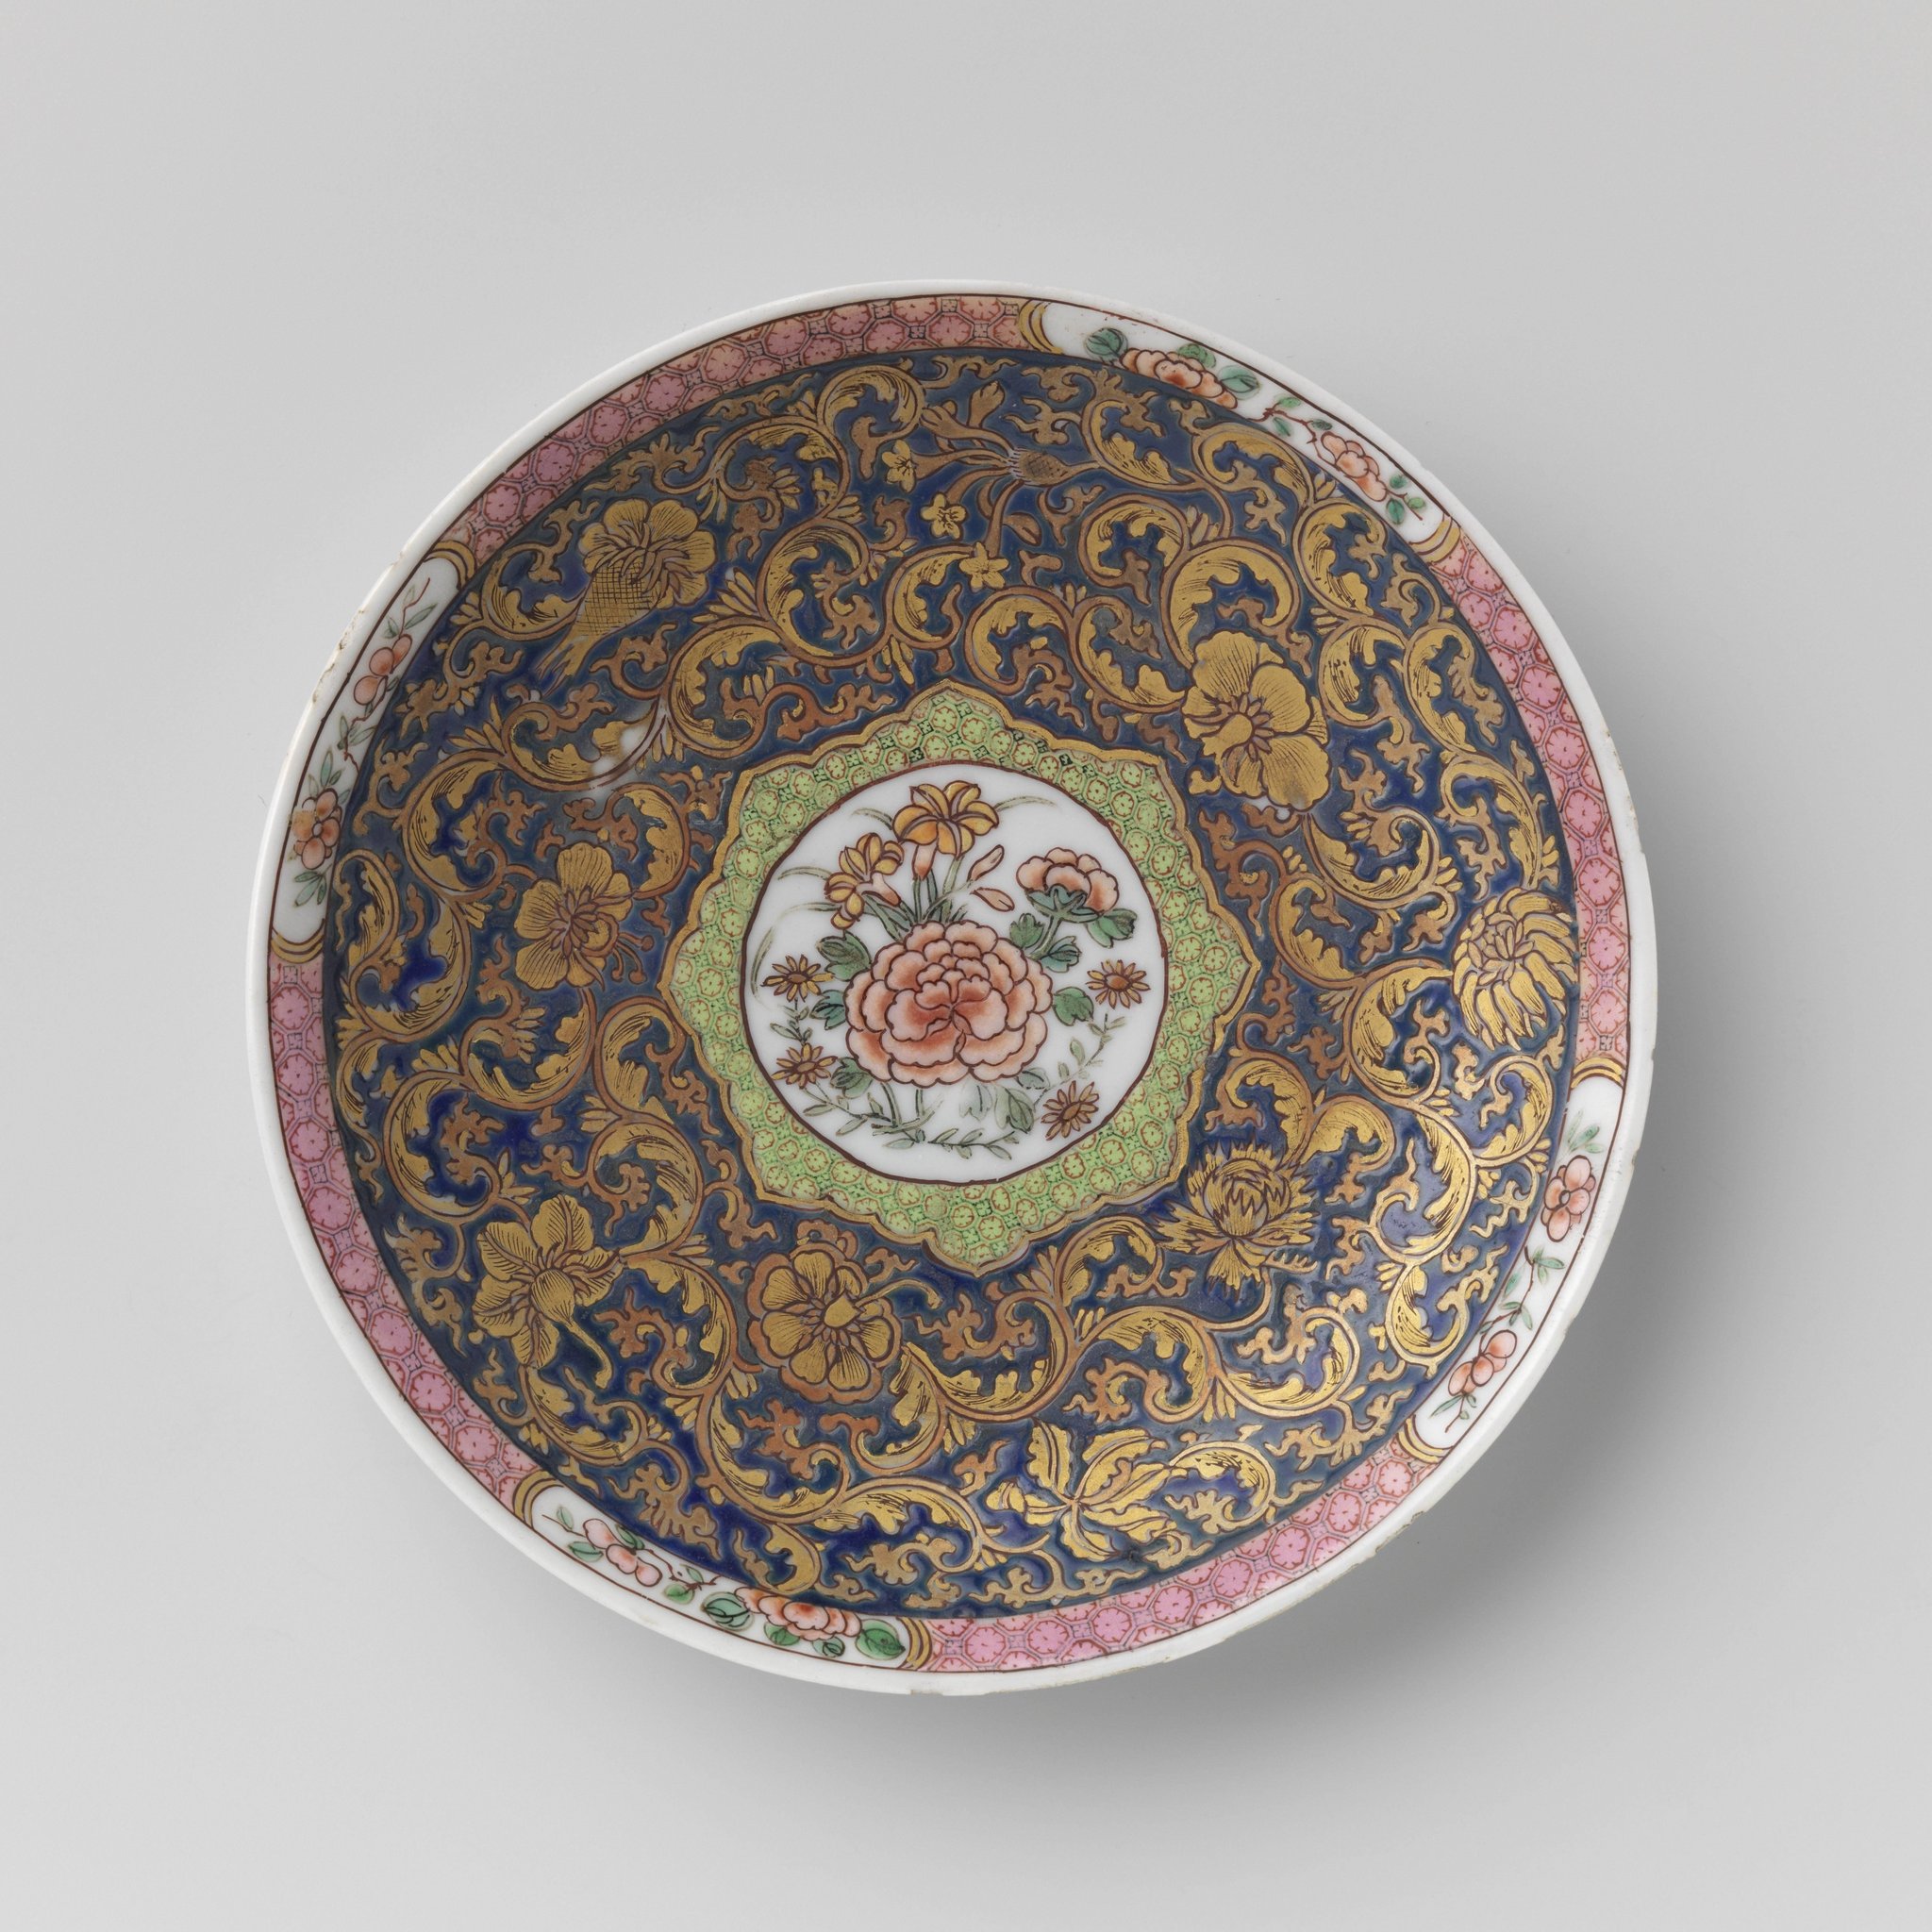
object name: platter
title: Saucer with large floral scrolls, diaper pattern and flower sprays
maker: Anonymous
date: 1725-1749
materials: glaze, gold, paint, porcelain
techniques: firing, gilding, turning, vitrification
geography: china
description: Schotel van porselein, beschilderd op het glazuur in blauw, rood, groen, geel, zwart en goud. Op het plat grote bloemranken met hierin uitgespaard een bloemvormig medaillon met bloemtakken (pioen, aster, ballonklokje); op de wand een band servetwerk afgewisseld met bloemtakken in een cartouche. Famille rose.